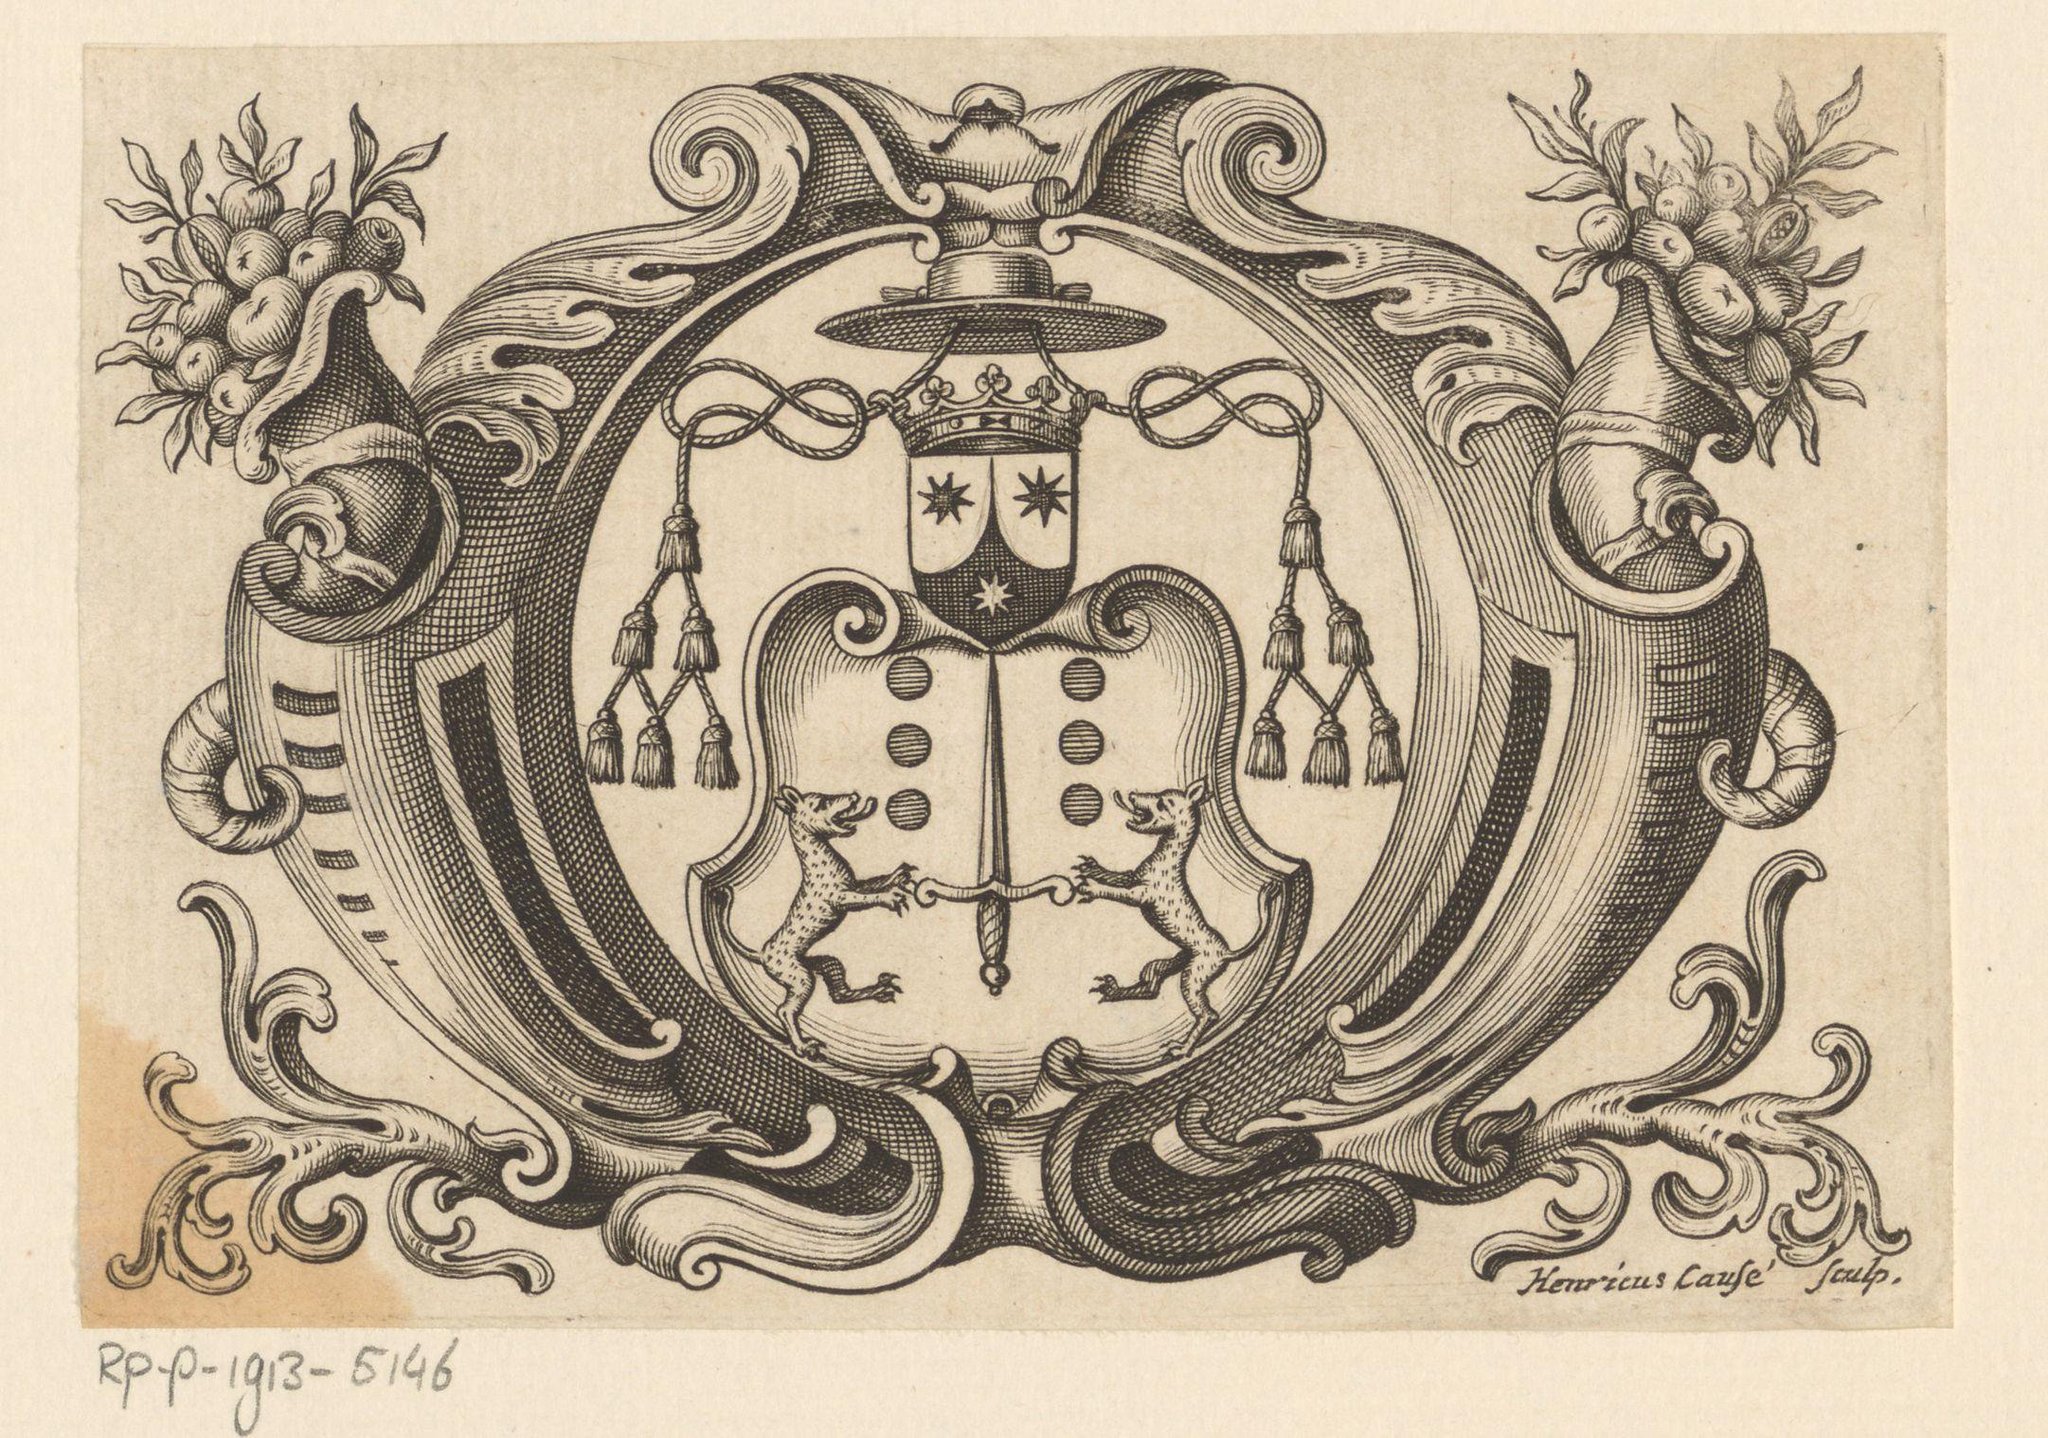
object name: bookplate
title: Ex libris van onbekend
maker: hendrik causé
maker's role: print maker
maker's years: 1648-1699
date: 1658-1699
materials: paper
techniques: engraving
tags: ornament ~ cartouche, armorial bearing, heraldry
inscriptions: collector's mark: Lugt 2233, collector's mark: Lugt 2760